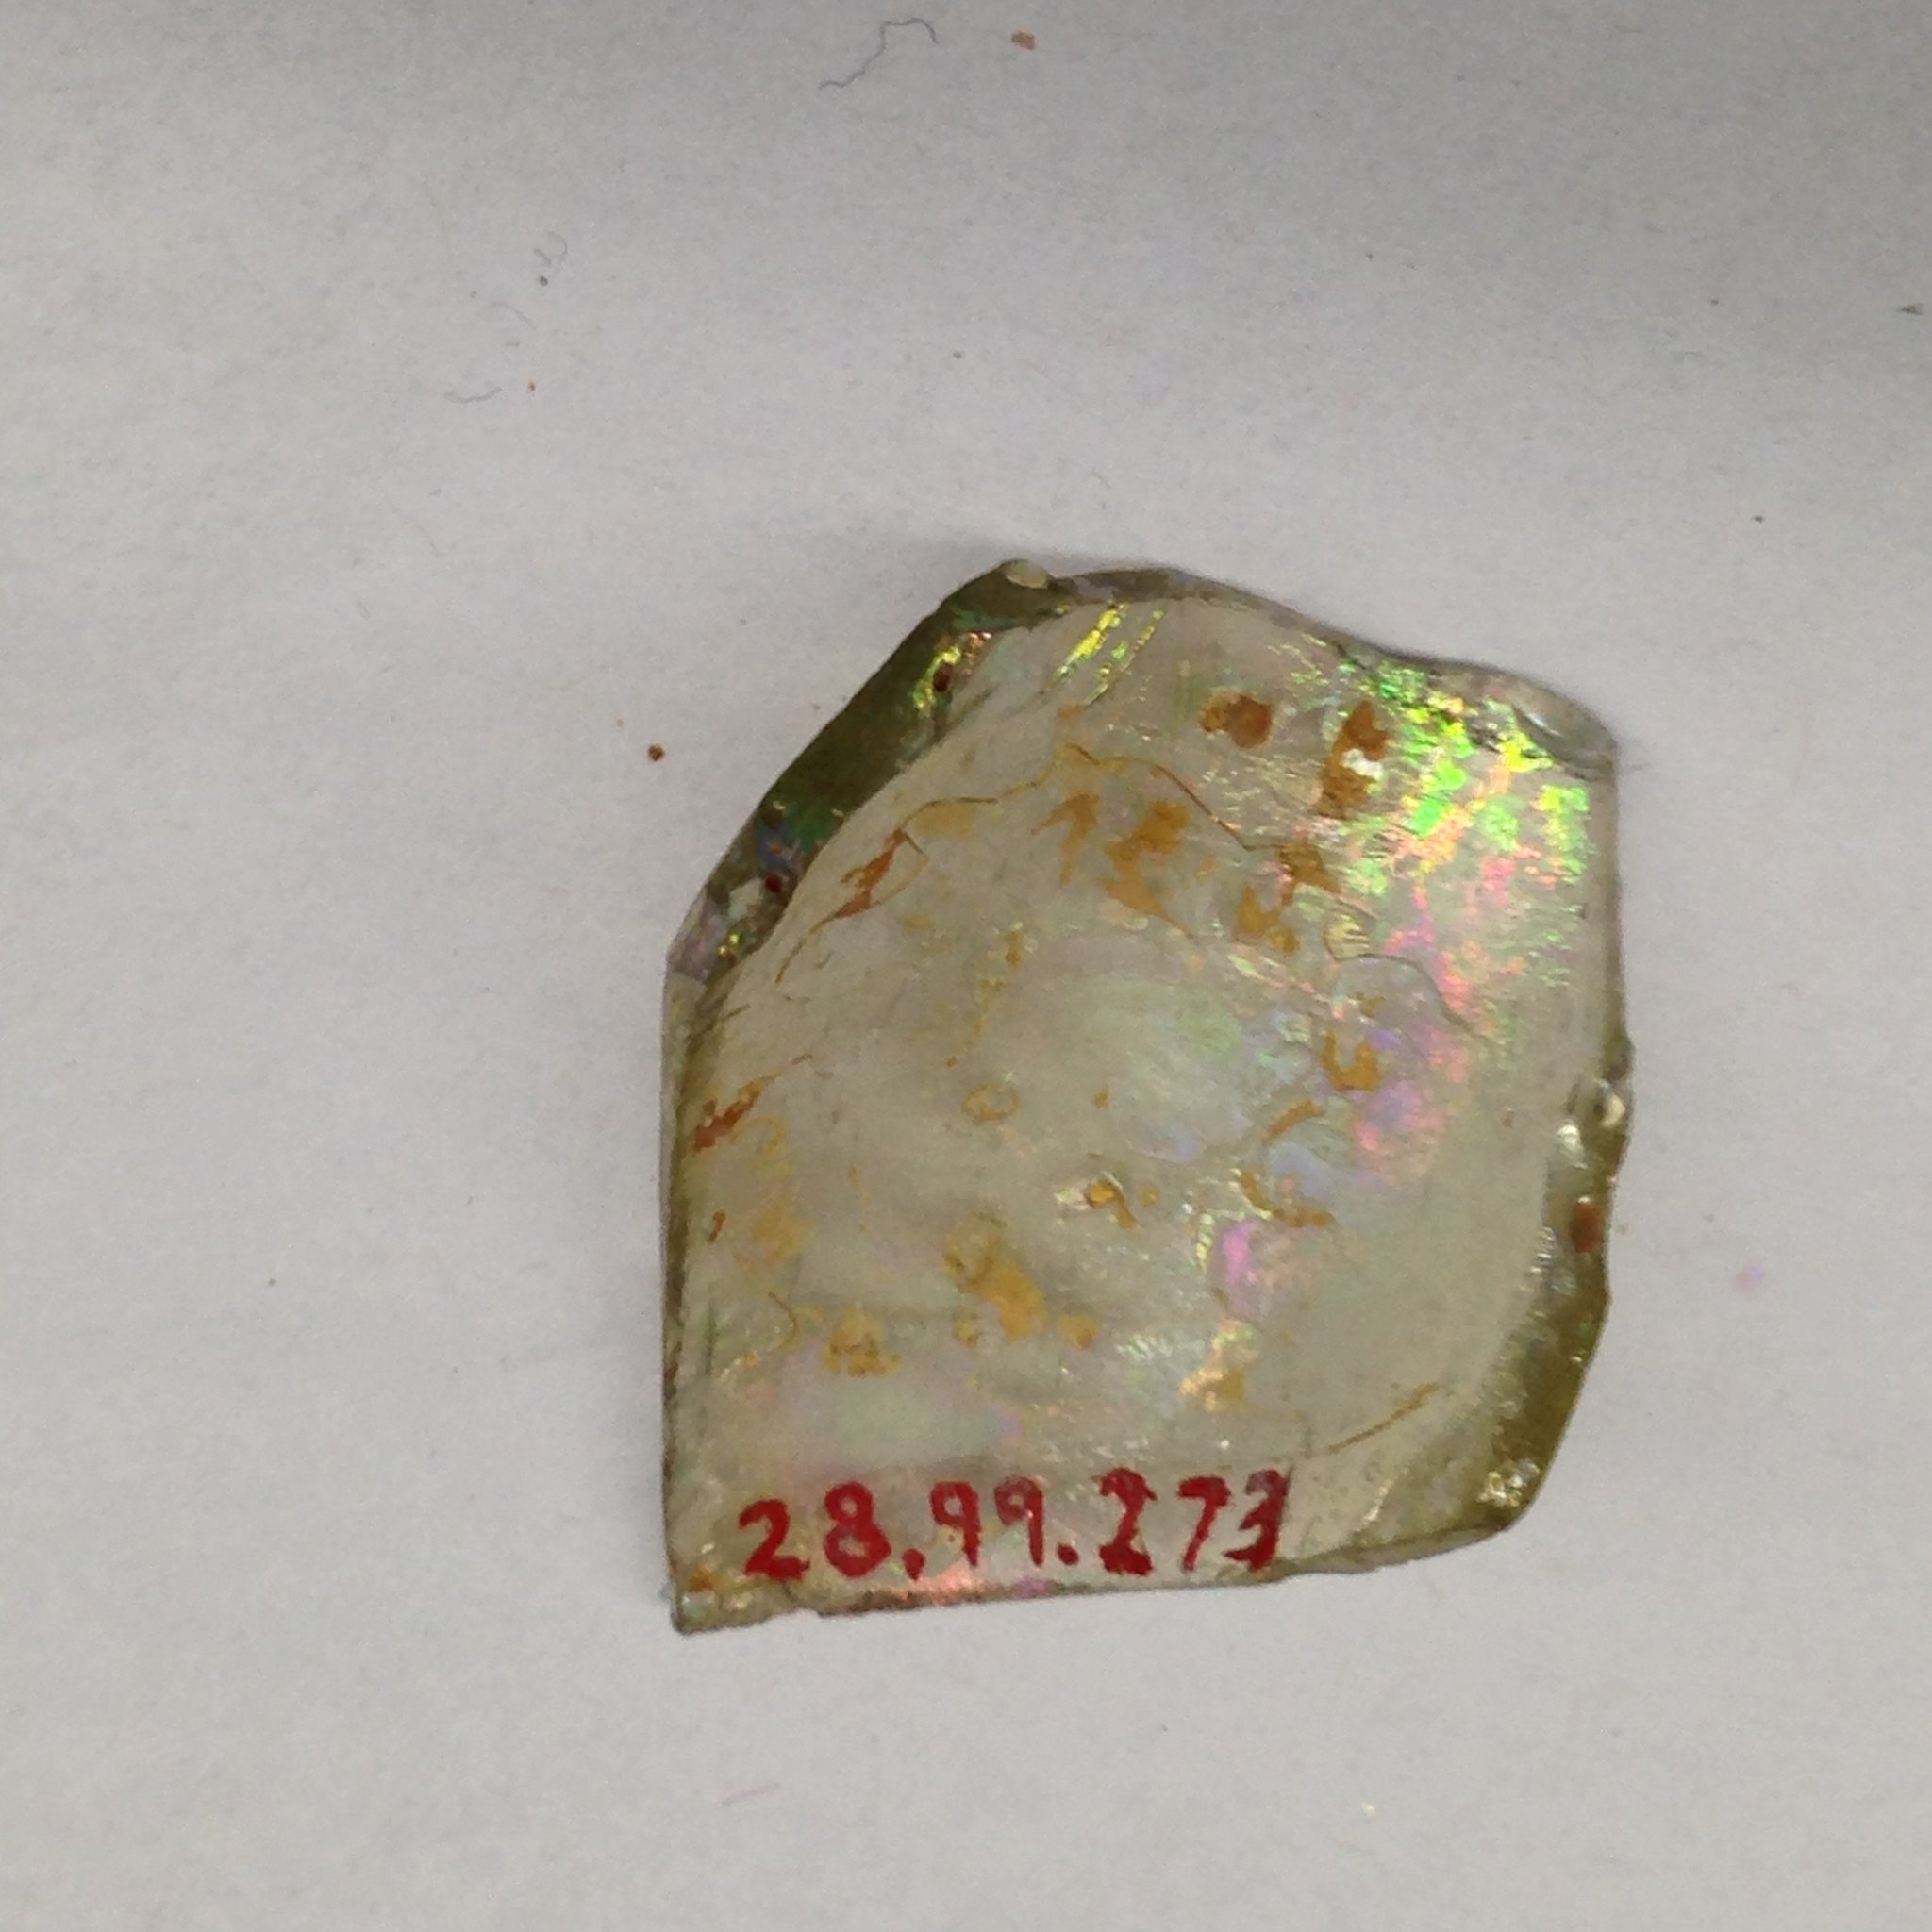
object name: fragment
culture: european or middle eastern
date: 1150-1250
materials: ceramic, glass